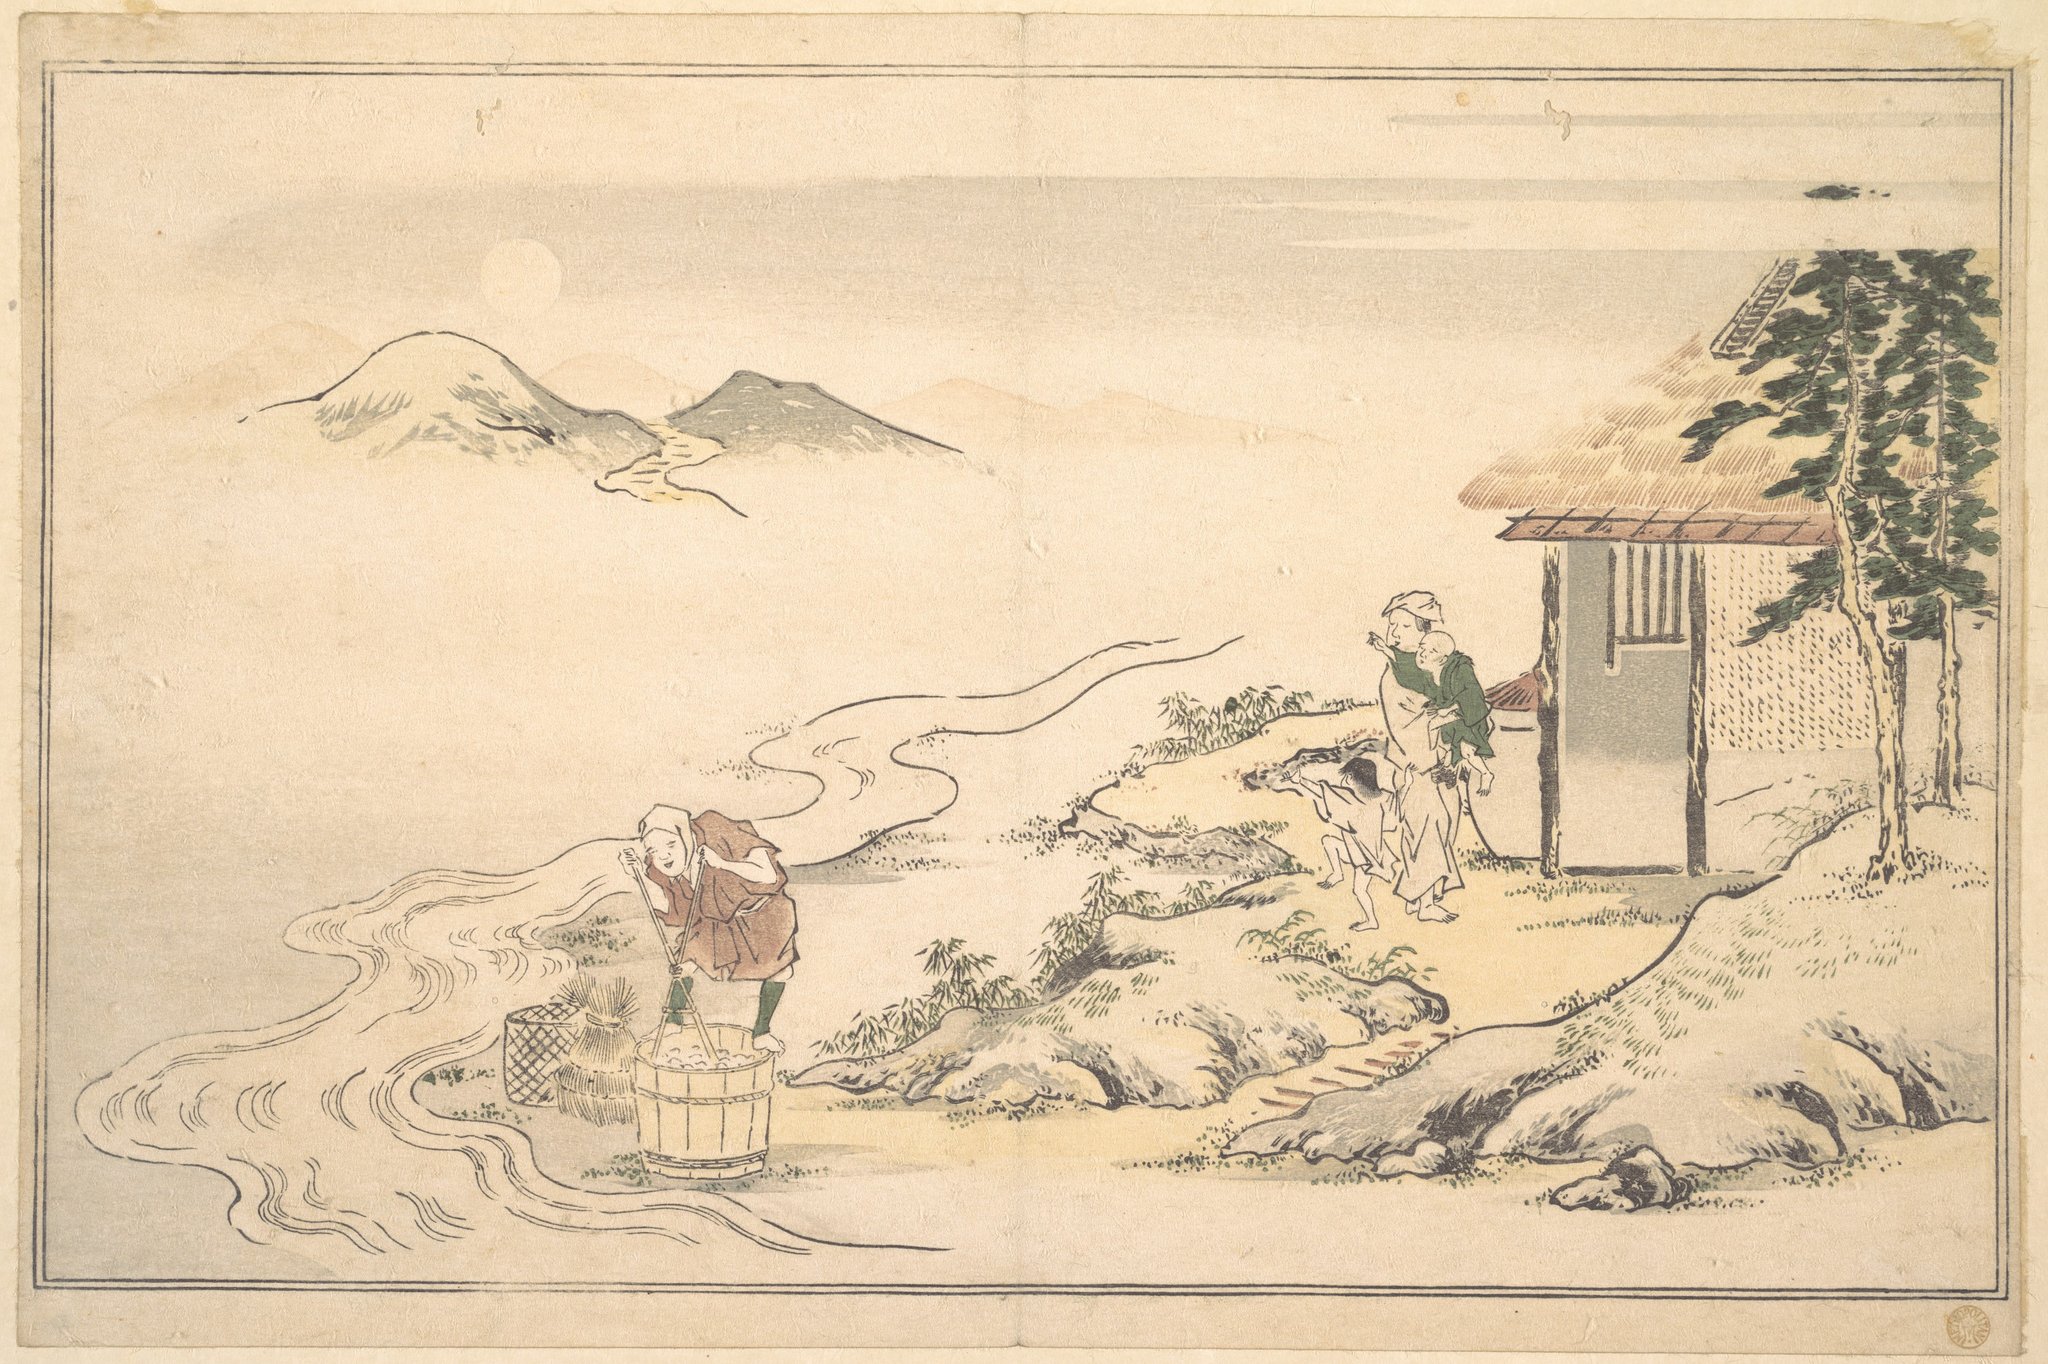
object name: print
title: The Full Moon at the Time of the Imo Harvest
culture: japanese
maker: kitagawa utamaro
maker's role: artist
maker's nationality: japanese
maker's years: 1754-1806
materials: ink, paper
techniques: woodblock print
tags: houses,children,moon,hills,trees